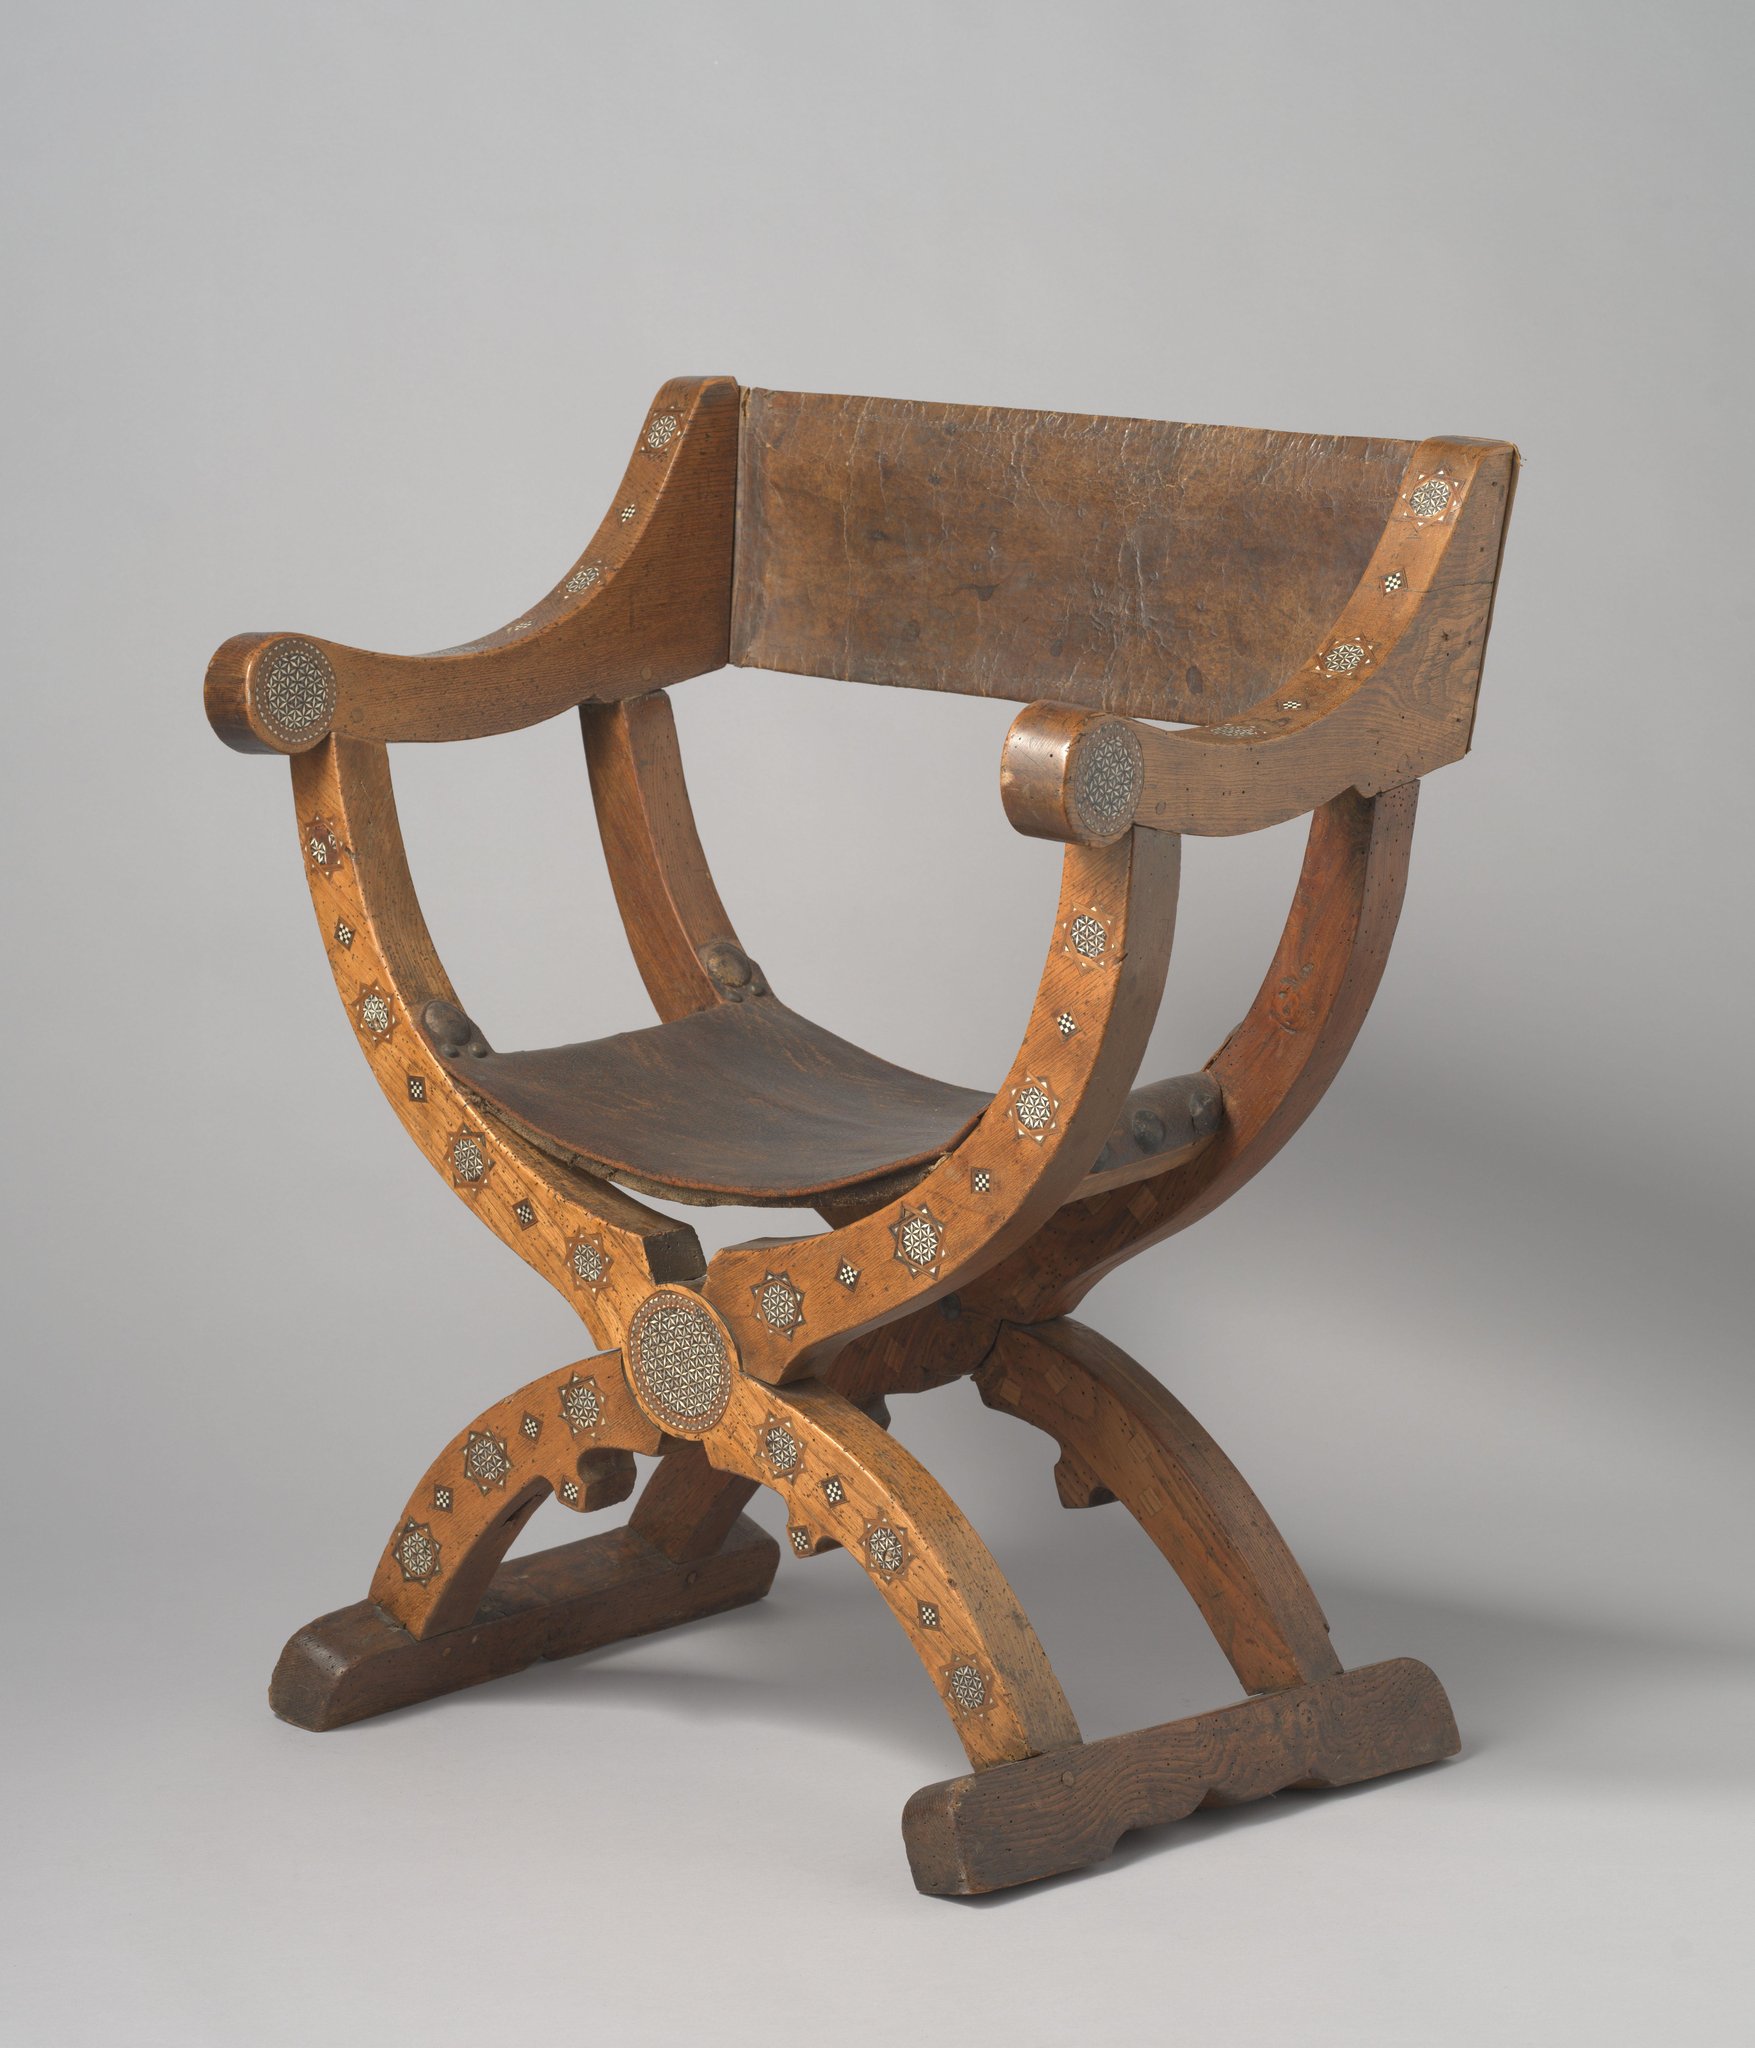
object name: chair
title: Vouwstoel, voorzijde poten, armleggers en stijlen ingelegd met ruitmotief waarbinnen afwisselend sterren en dambordmotief.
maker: Anonymous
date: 1500-1600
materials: bone, wood, mother of pearl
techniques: marquetry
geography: northern italy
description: Vouwstoel van iepenhout met leren rug en zitting en rustend op halfcirkelvormige poten, die met halfcirkelvormige stijlen in verbinding staan. De poten staan op verbindingsklossen. De armleggers eindigen in voluten en lopen omhoog in de rugstijlen. De voorzijde der poten, de stijlen en de bovenzijde der armleggers zijn ingelegd in een ruiten- met dambordmotief, afgewisseld met ruiten met sterrenvelden en concentrische cirkels, in de certosina-techniek uitgevoerd in been, parelmoer en diverse houtsoorten.